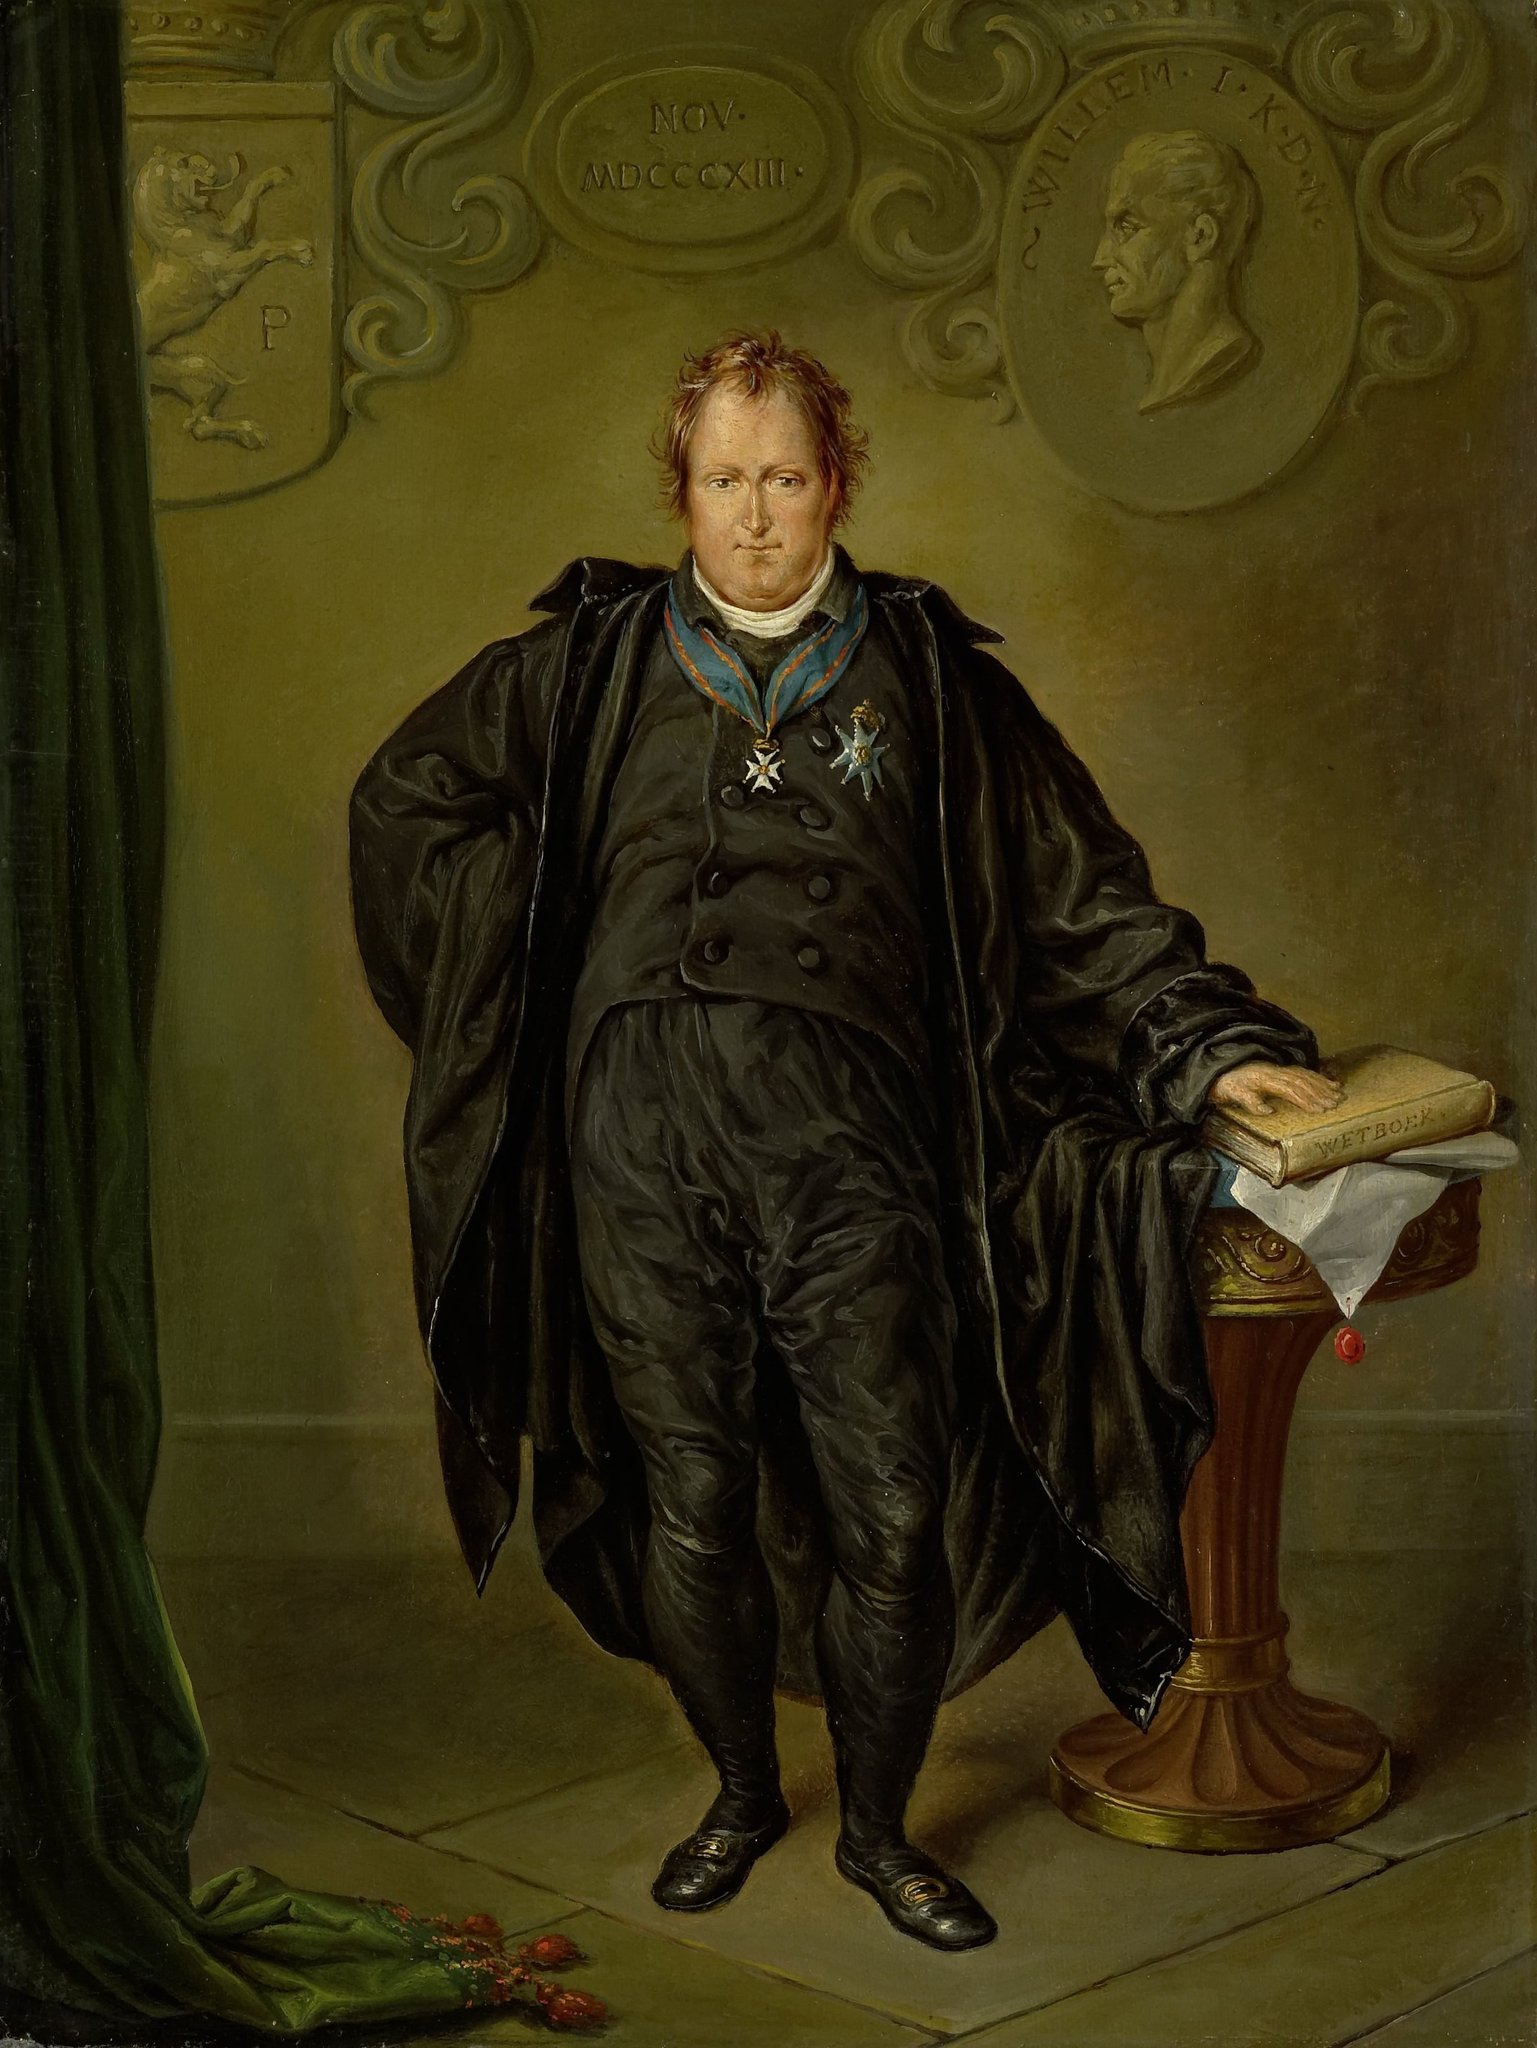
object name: painting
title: Johan Melchior Kemper (1776-1824), Jurist and Statesman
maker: david pièrre giottino humbert de superville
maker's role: draughtsman, painter, print maker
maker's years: 1770-1849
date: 1815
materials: oil, panel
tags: amsterdam, jonkheer joan melchior kemper, historical persons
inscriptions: date: ‘NOV. MDCCCXIII’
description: Joan Melchior Kemper (1776 - 1824) by D.P.G. Humbert de Superville, c. 1815. Former Patriot Kemper was the author of the proclamation with which Prince William of Orange presented himself as 'William I, sovereign lord' on 2 December 1813, a few days after arriving in the Netherlands. In it William I promised a constitution guaranteeing the freedom of his subjects. As a professor the jurist Kemper was the mentor of many later politicians such as Thorbecke and Groen van Prinsterer. In 1817 Kemper became a member of the Lower House. Kemper's decorations are the symbols of Commander of the Orde van de Nederlandse Leeuw. The order was established in 1815. Kemper was a personal friend of the painter. Humbert gave Kemper's daughters drawing lessons. And Kemper had ensured that Humbert was appointed lecturer at Leiden University in 1814.